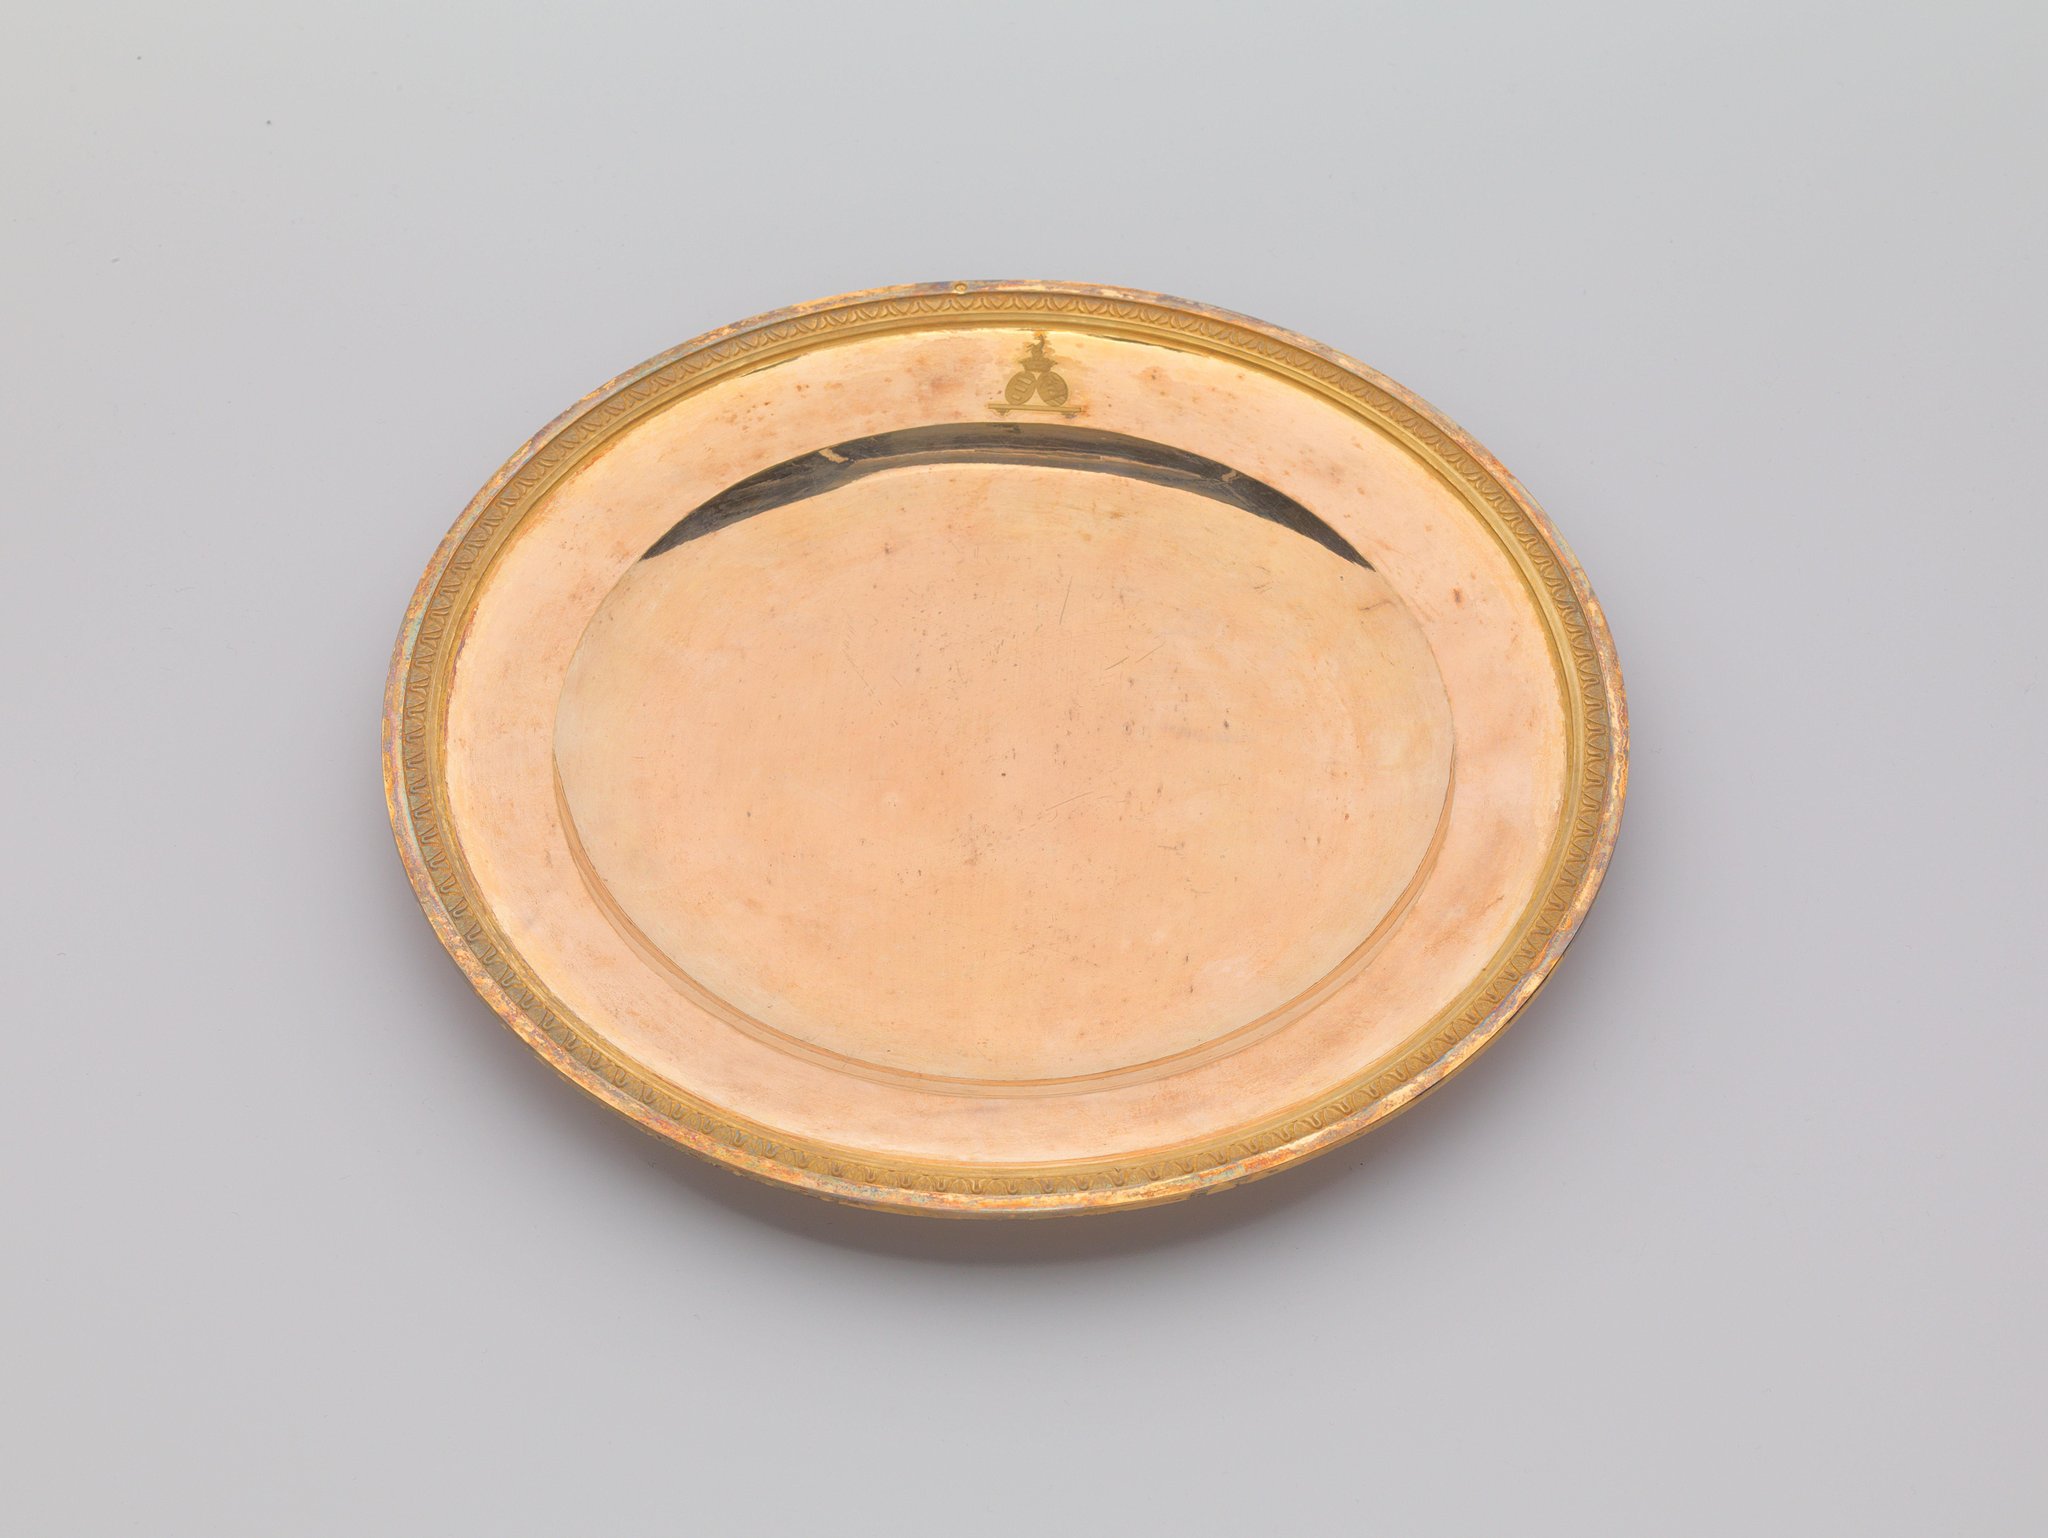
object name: plate dish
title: Bord van verguld zilver, met palmetrand. Op het plat het gegraveerde wapen Potemkin.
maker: Anonymous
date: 1809-1819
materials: silver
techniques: gilding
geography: paris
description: Empire bord van verguld zilver. Omgeven door een palmetrand. In het plat het gegraveerde wapen van Potemkin.